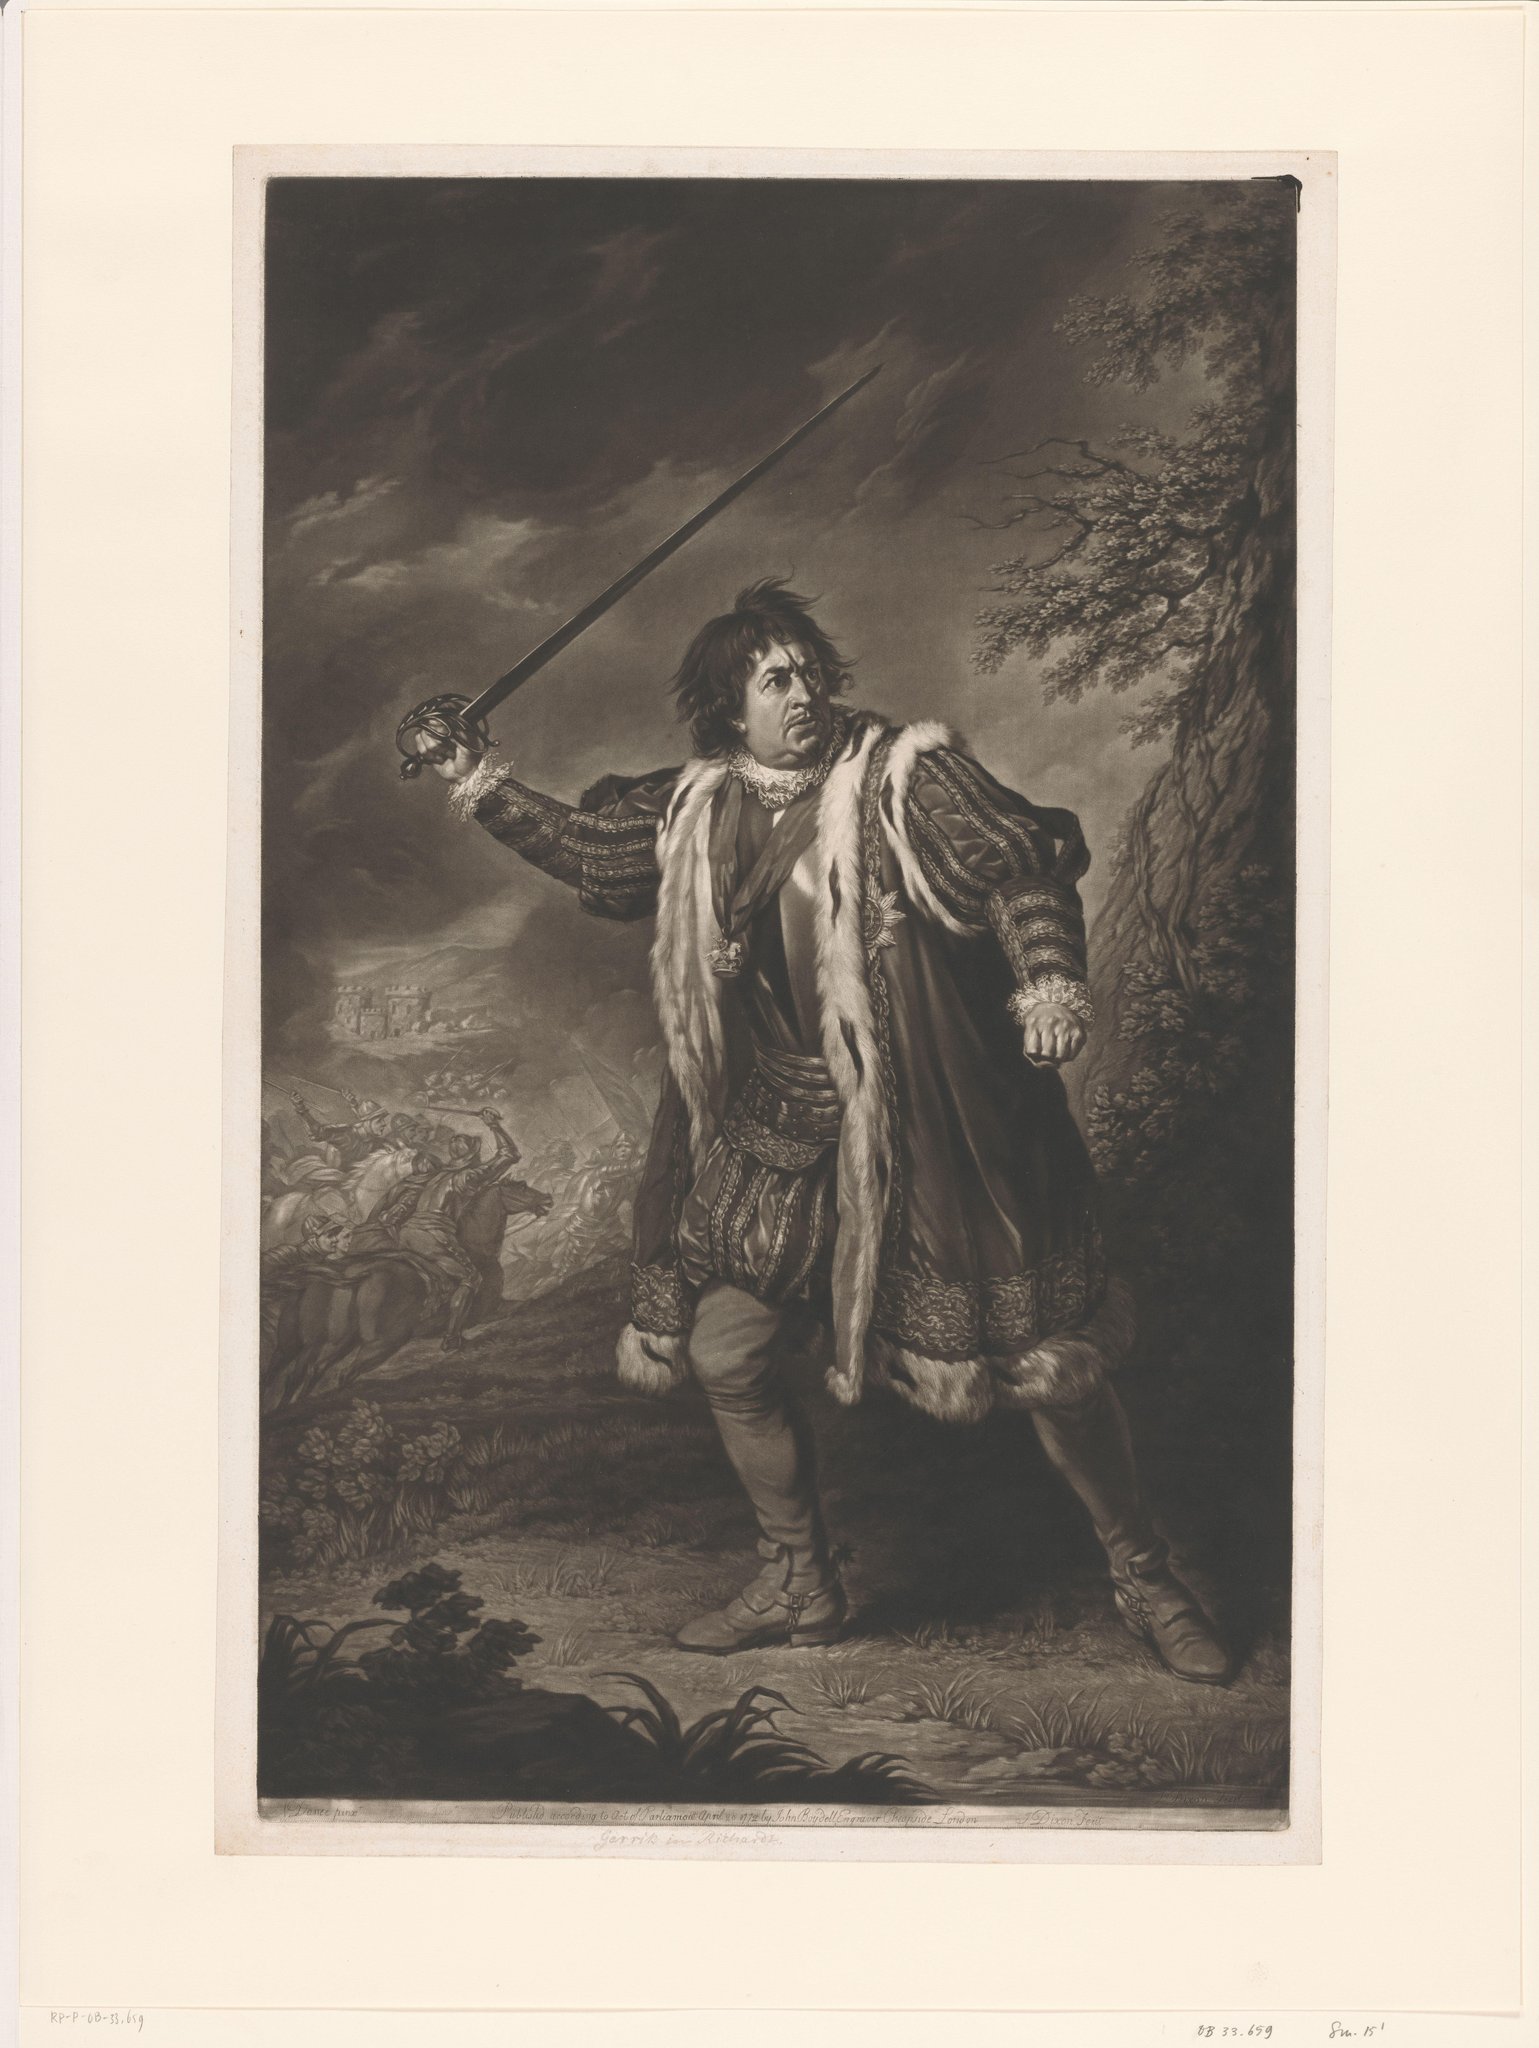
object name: print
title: Portret van David Garrick als Richard III, koning van Engeland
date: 1772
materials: paper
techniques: mezzotint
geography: london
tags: london, david garrick, historical persons, portrait of actor, actress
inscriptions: collector's mark: Lugt 240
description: De beroemde toneelspeler David Garrick (1717-1779) maakte in 1741 zijn debuut in de rol van Richard de Derde in het gelijknamige toneelstuk van Shakespeare.Zijn speltechniek was naturalistisch en revolutionair en werd met enthousiasme door het Engelse publiek begroet. Garrick heeft de rol van Richard de Derde talloze malen gespeeld en is als zodanig door meer dan één kunstenaar in verschillende scènes afgebeeld. Hier is de koning als een monumentale heldenfiguur op het slagveld weergegeven.